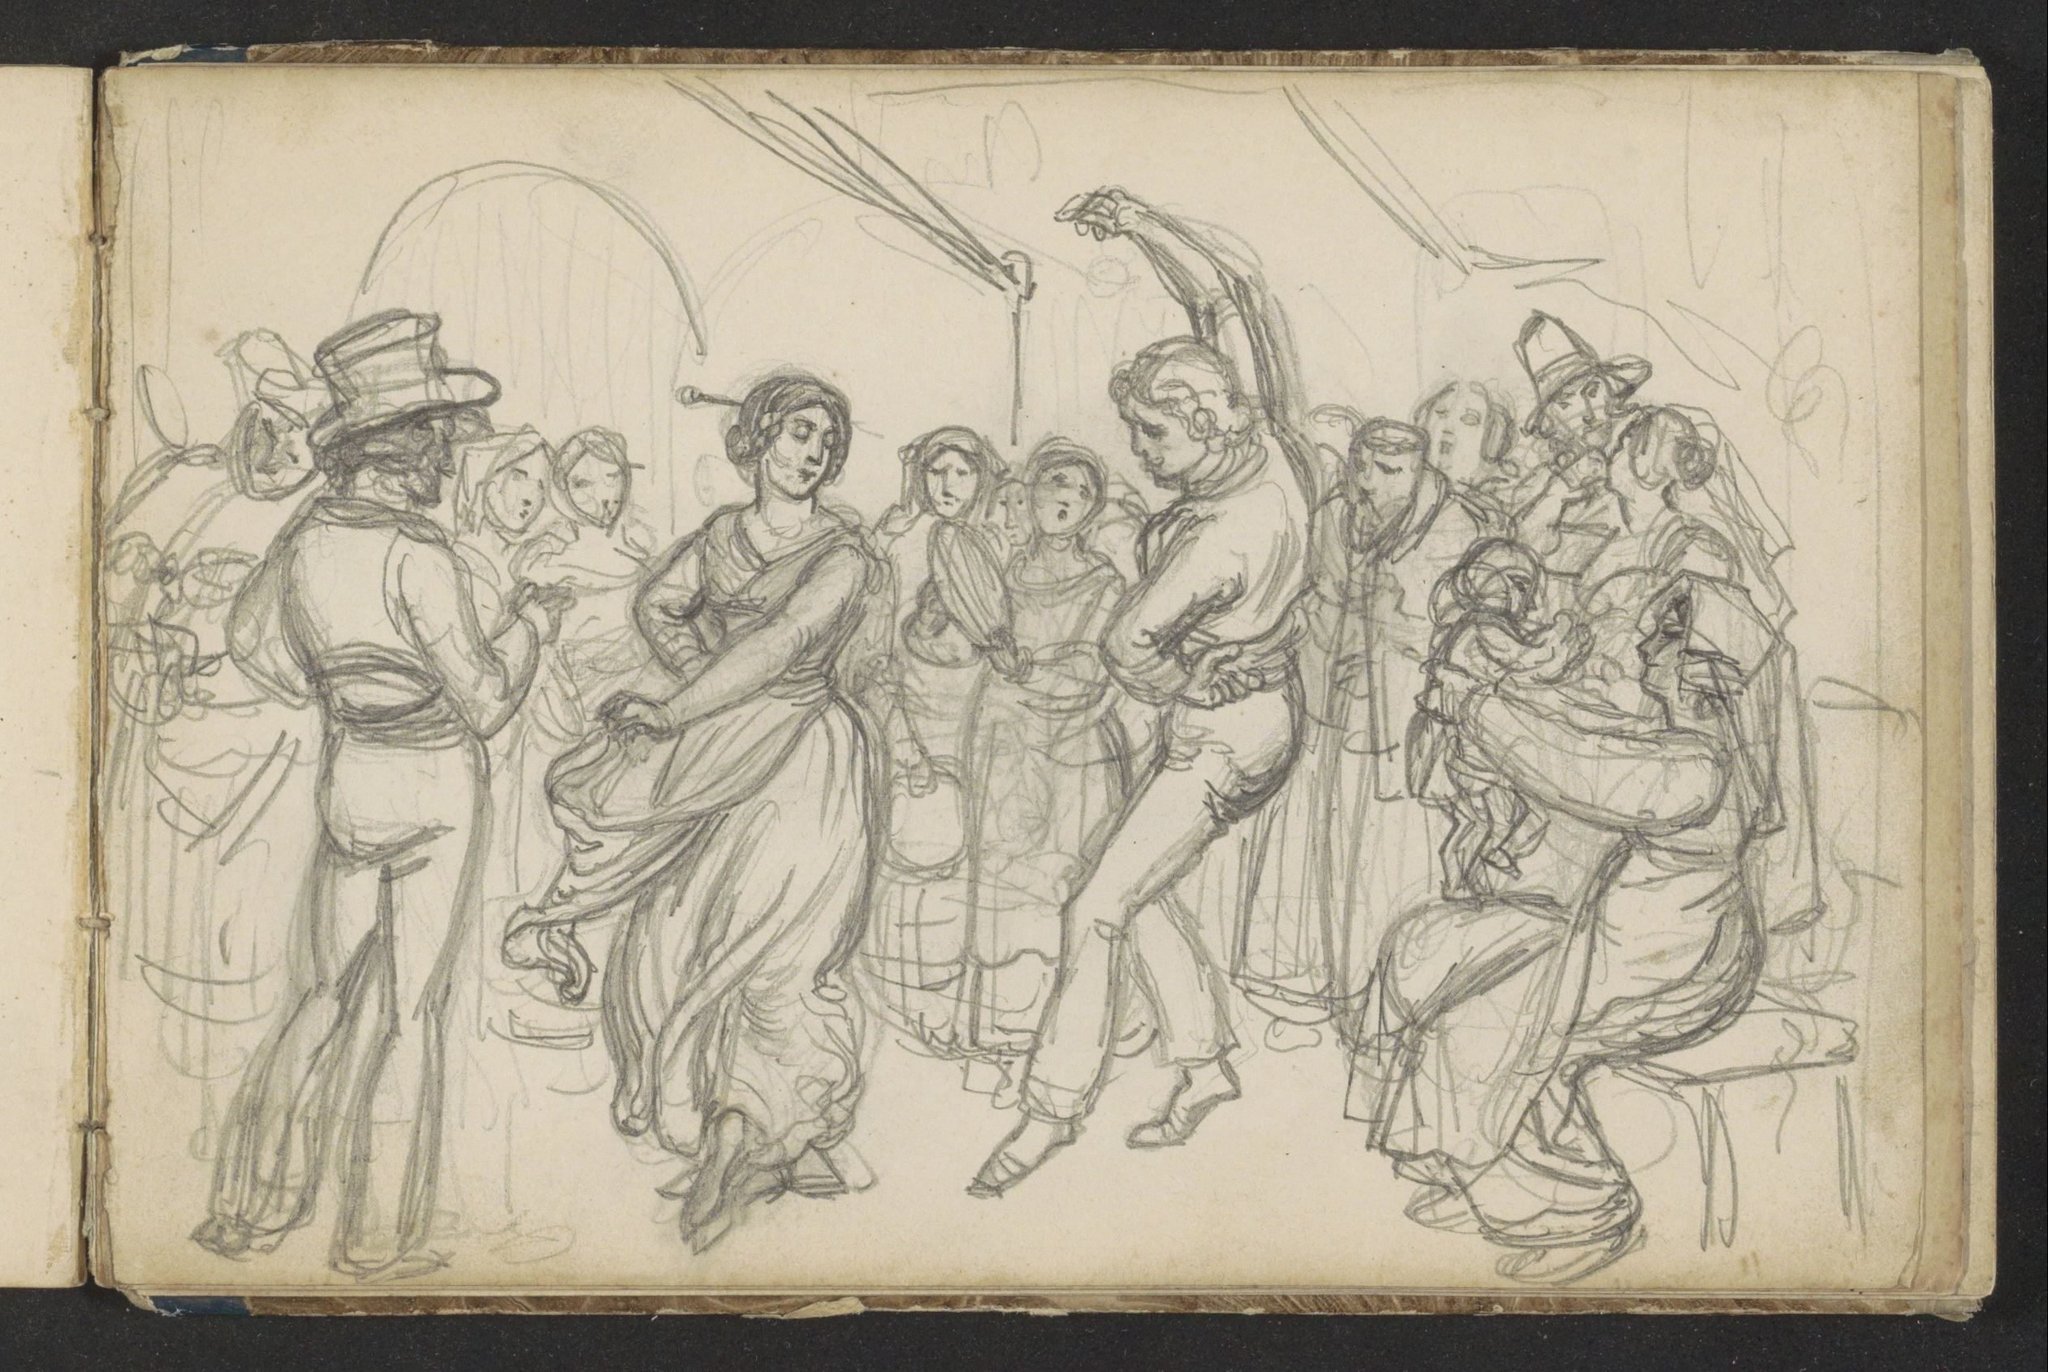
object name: sketchbook leaf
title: Dansend paar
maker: Anonymous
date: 1841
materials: paper, pencil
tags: one pair dancing; man and woman dancing as a couple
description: Interieur met een dansend paar omringd en aangemoedigd door een groep mensen. Blad 21 recto uit een schetsboek met 33 bladen.